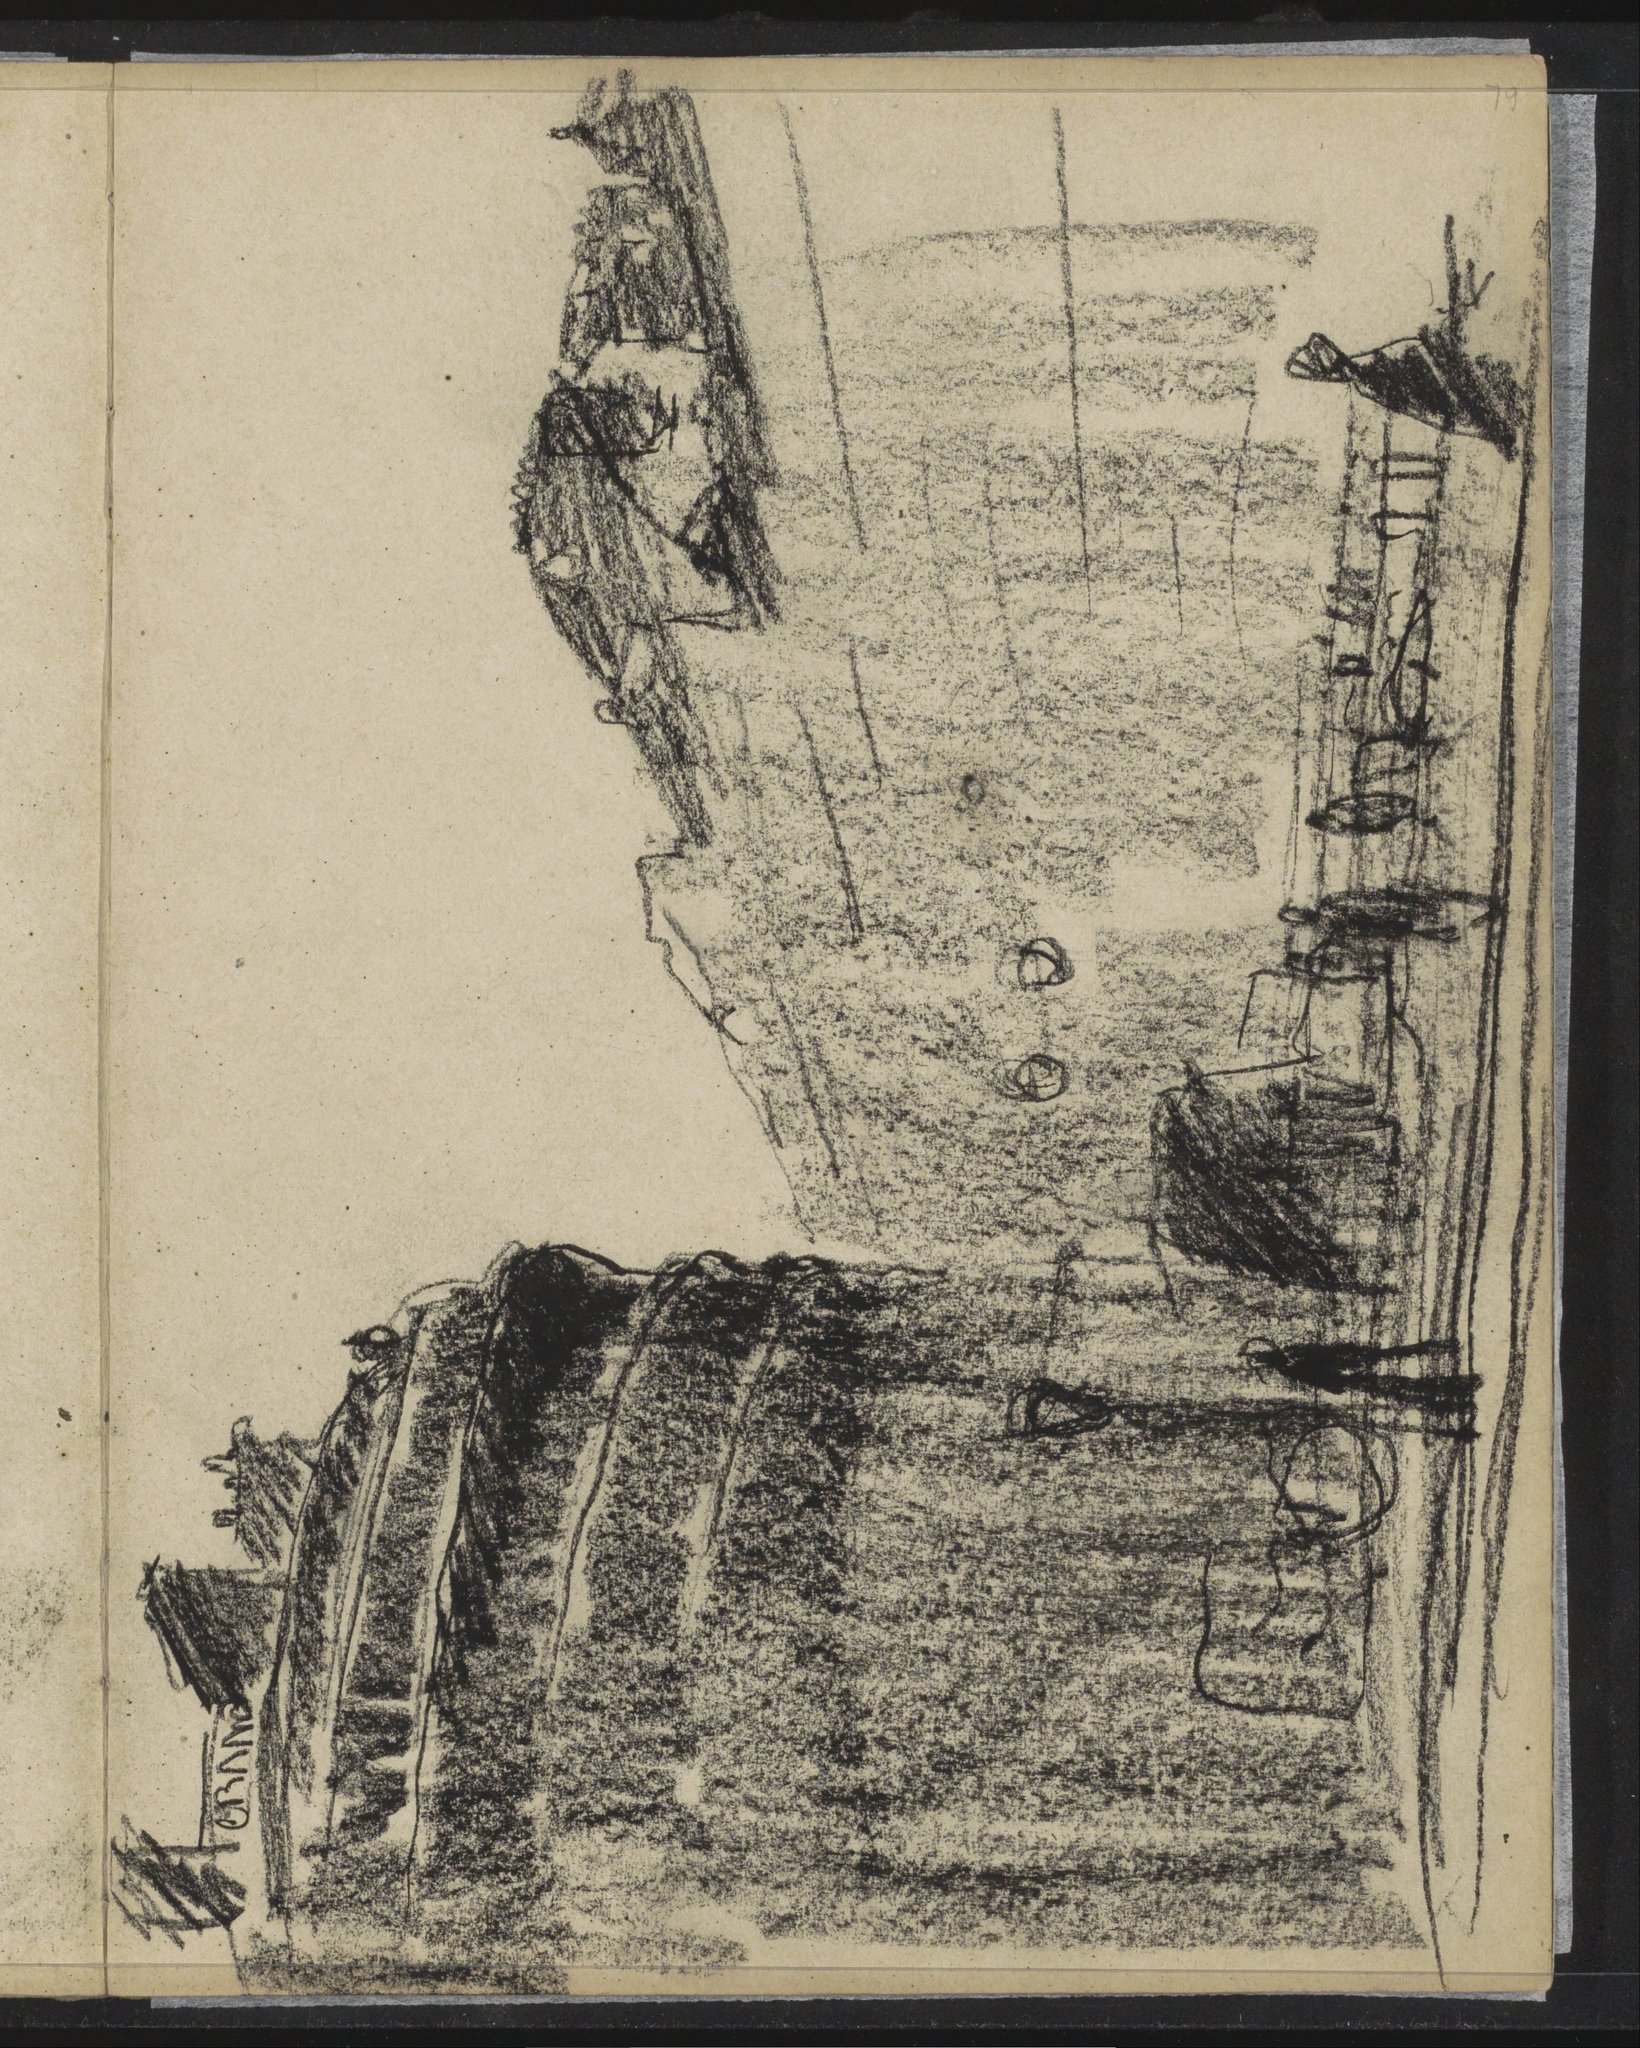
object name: sketchbook leaf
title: Gezicht op Trafalgar Square en Northumberland Ave met The Grand te Londen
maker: willem witsen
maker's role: draughtsman, painter, print maker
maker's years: 1860-1923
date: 1888-1891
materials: chalk, paper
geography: london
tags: civic architecture; edifices; dwellings, square, place, circus, etc. (+ city(-scape) with figures, staffage), street (+ city(-scape) with figures, staffage)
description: Pagina 79 uit een schetsboek met 49 bladen.